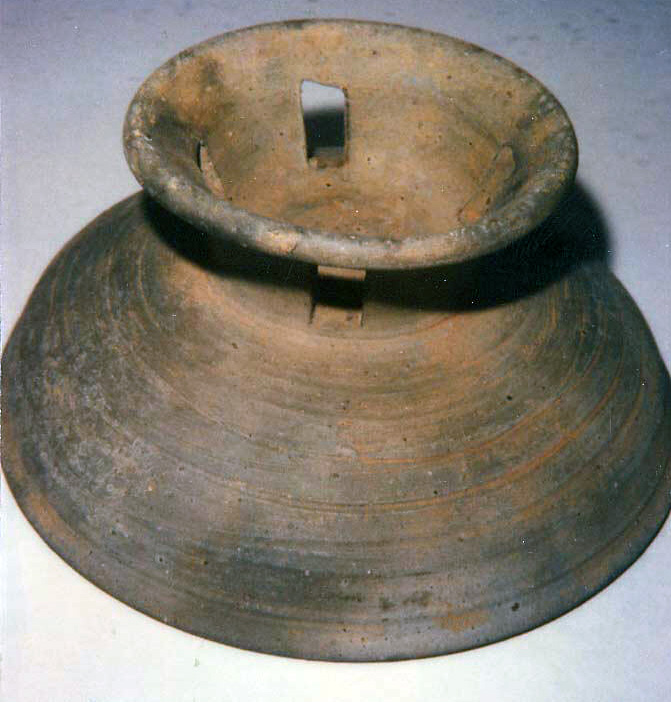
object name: lid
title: Lid with Perforated Top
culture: korean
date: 401-700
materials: porcelain